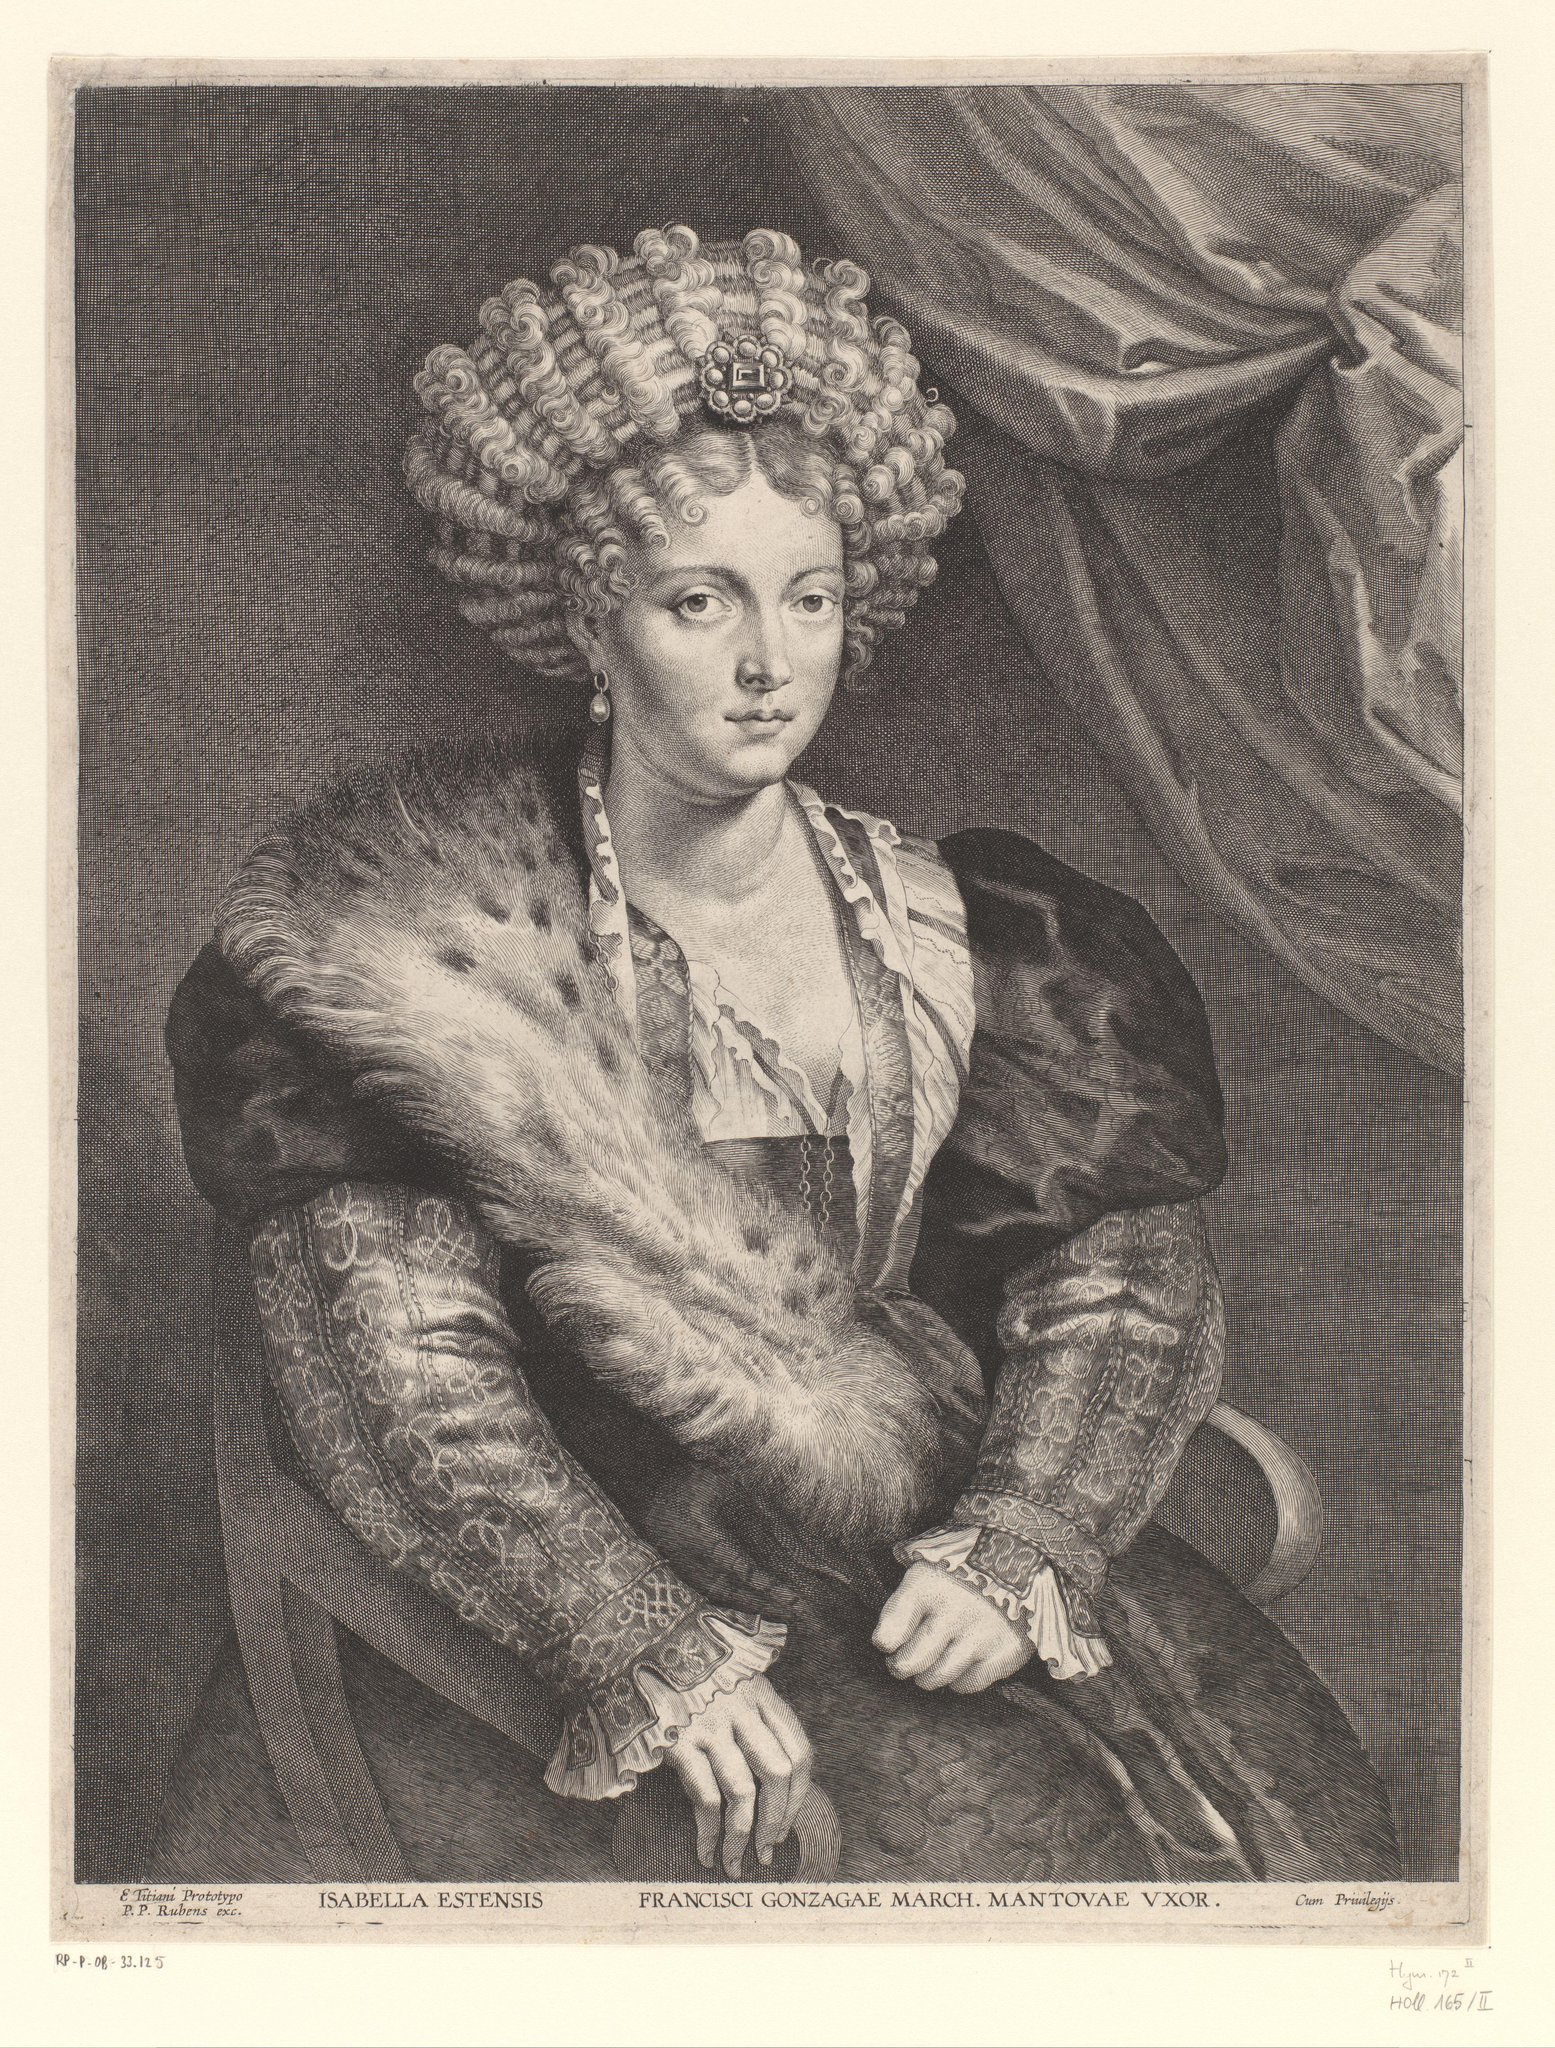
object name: print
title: Portret van Isabella d'Este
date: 1619-1675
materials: paper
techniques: engraving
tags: ferrara (stad), markiezin, isabella d' este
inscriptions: collector's mark: Lugt 240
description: Portret van Isabella D'Este, markiezin van Mantua.